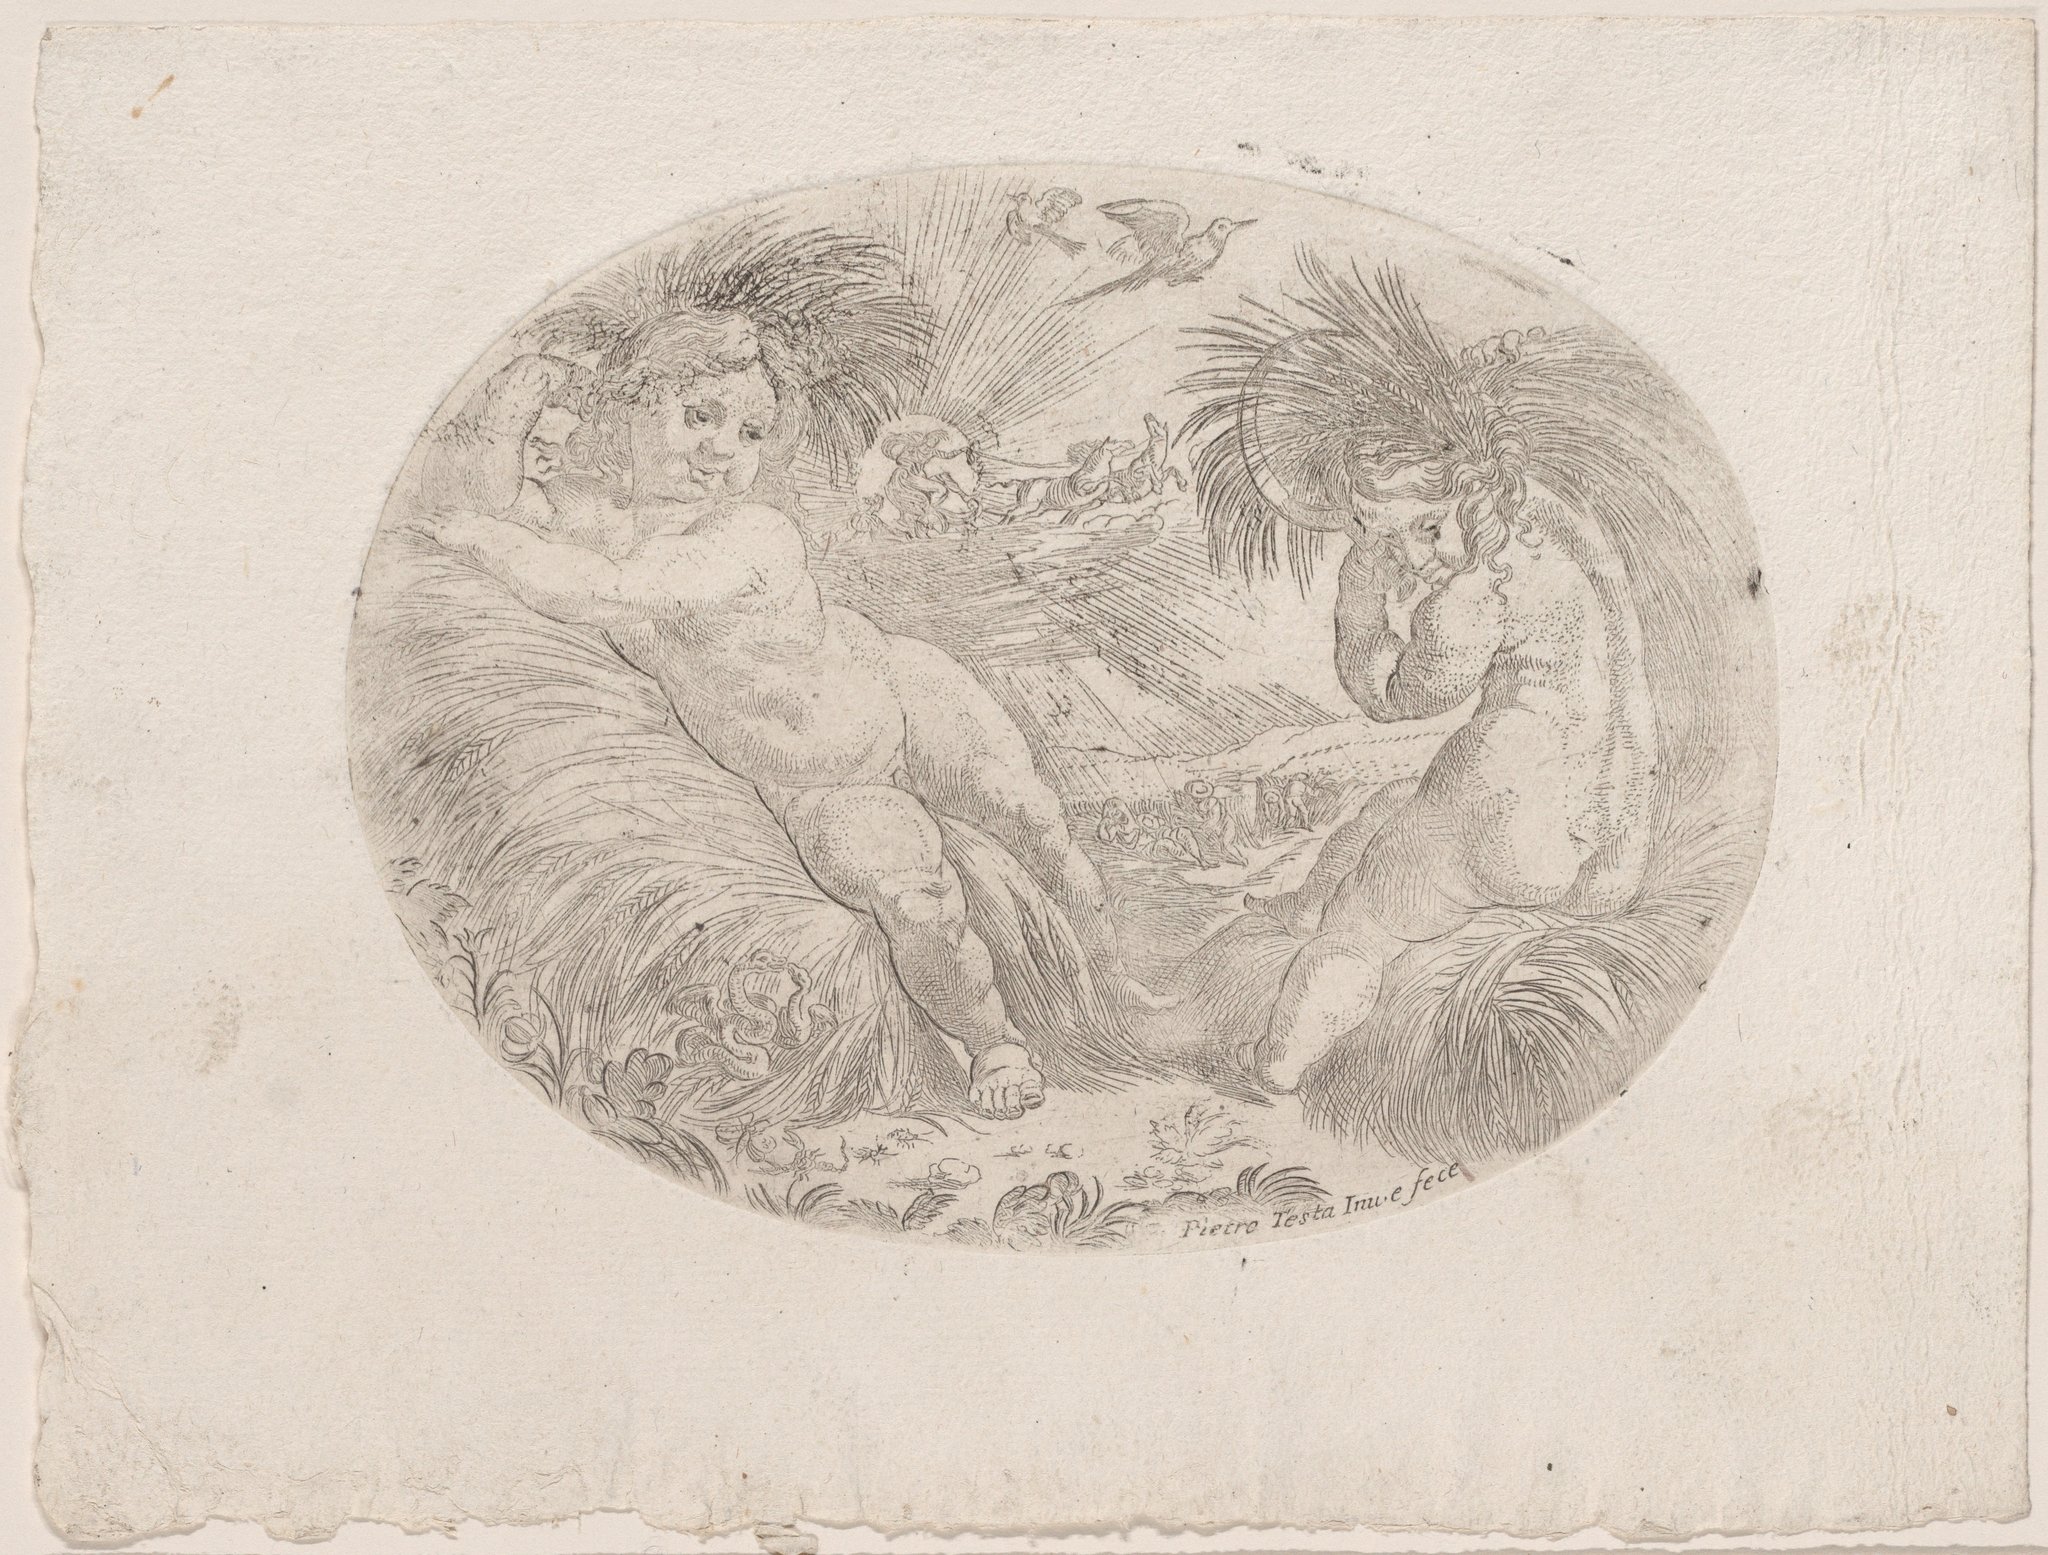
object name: print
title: Putto at left reclining on sheaves of wheat, another at right carrying a sheave over his shoulder, an allegory of the seasons (Summer), an oval composition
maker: anonymous, 17th century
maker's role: artist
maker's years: 1600-1700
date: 1650-1680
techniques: etching